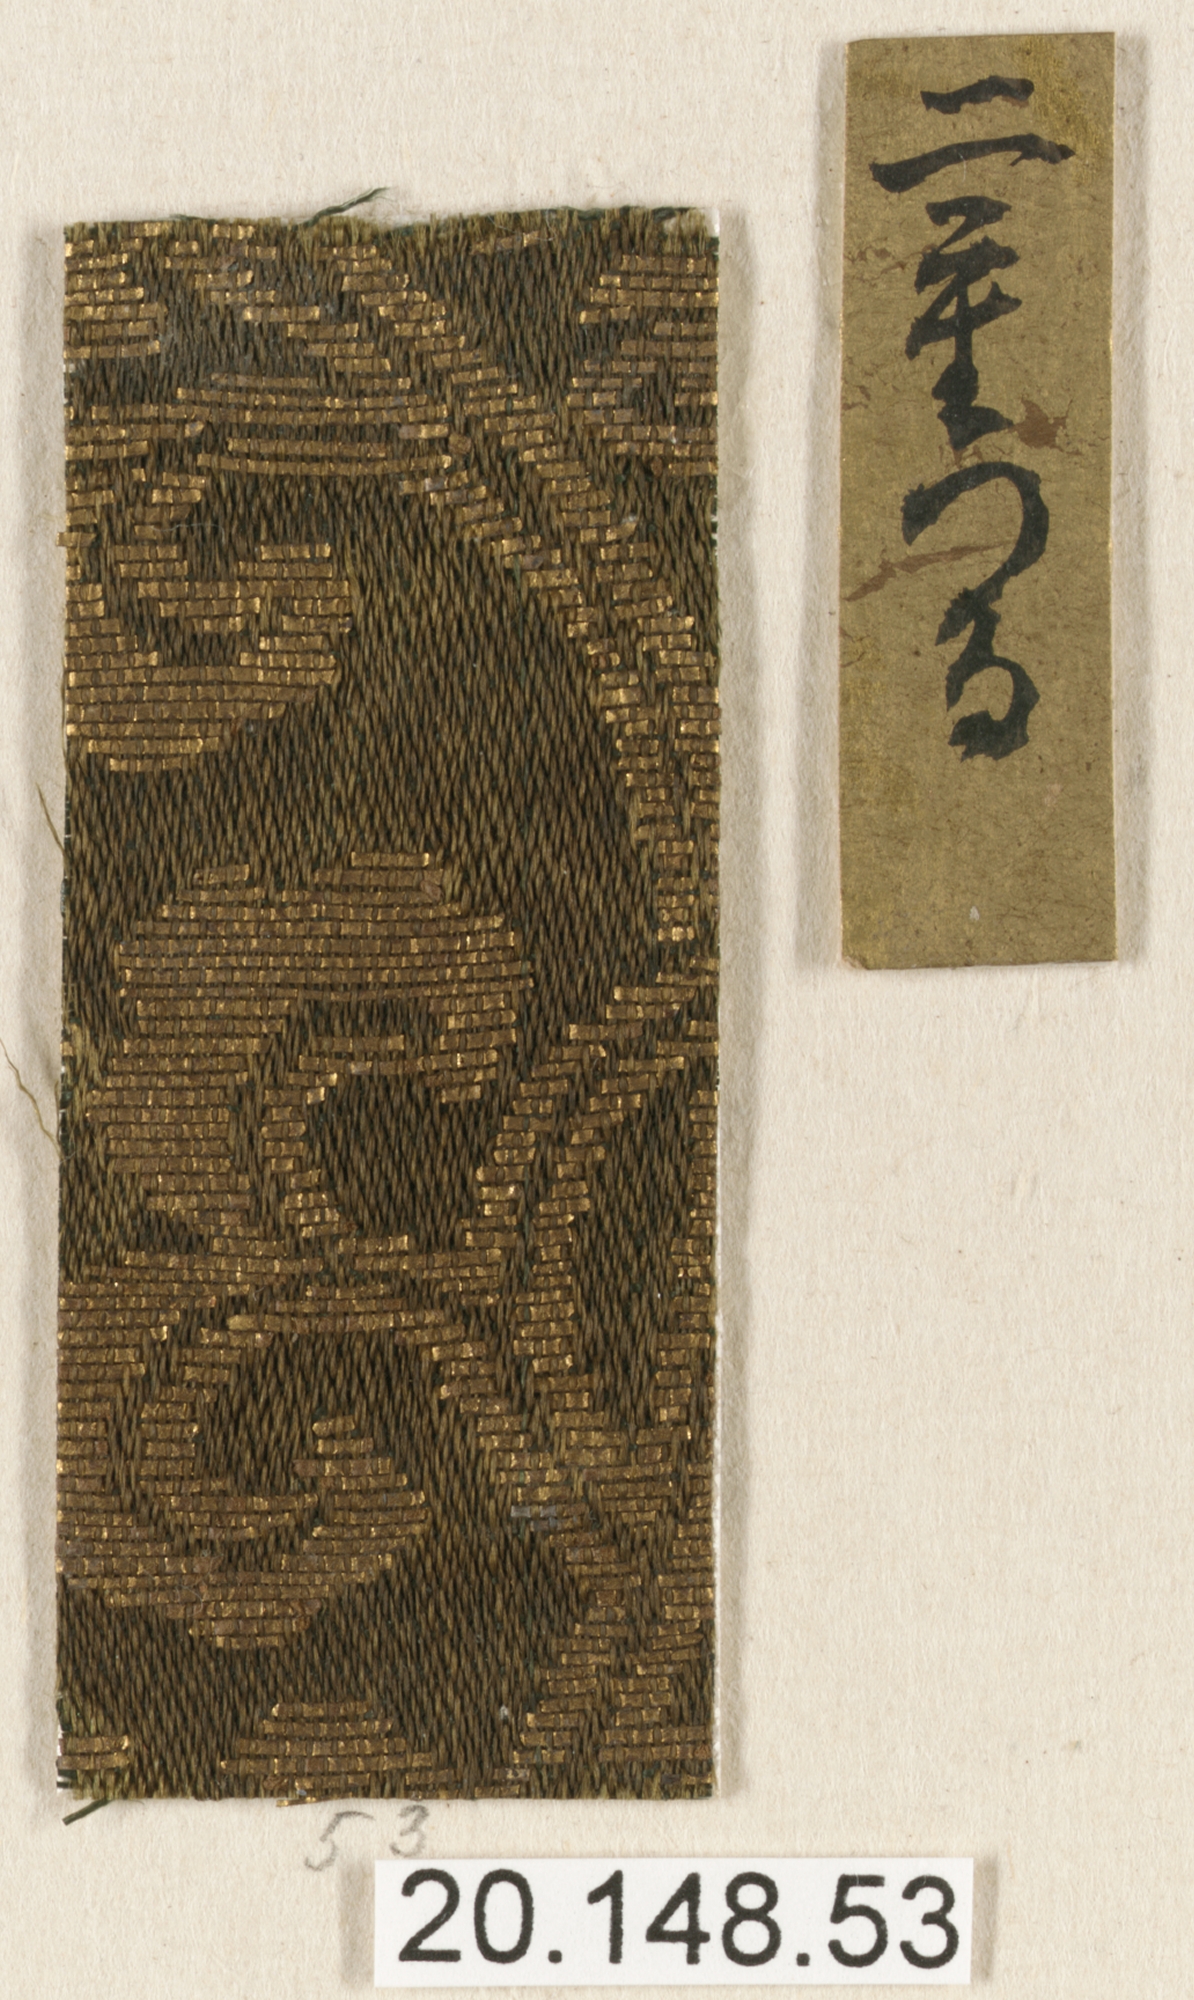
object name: piece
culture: japanese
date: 1501-1600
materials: silk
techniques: compound weave